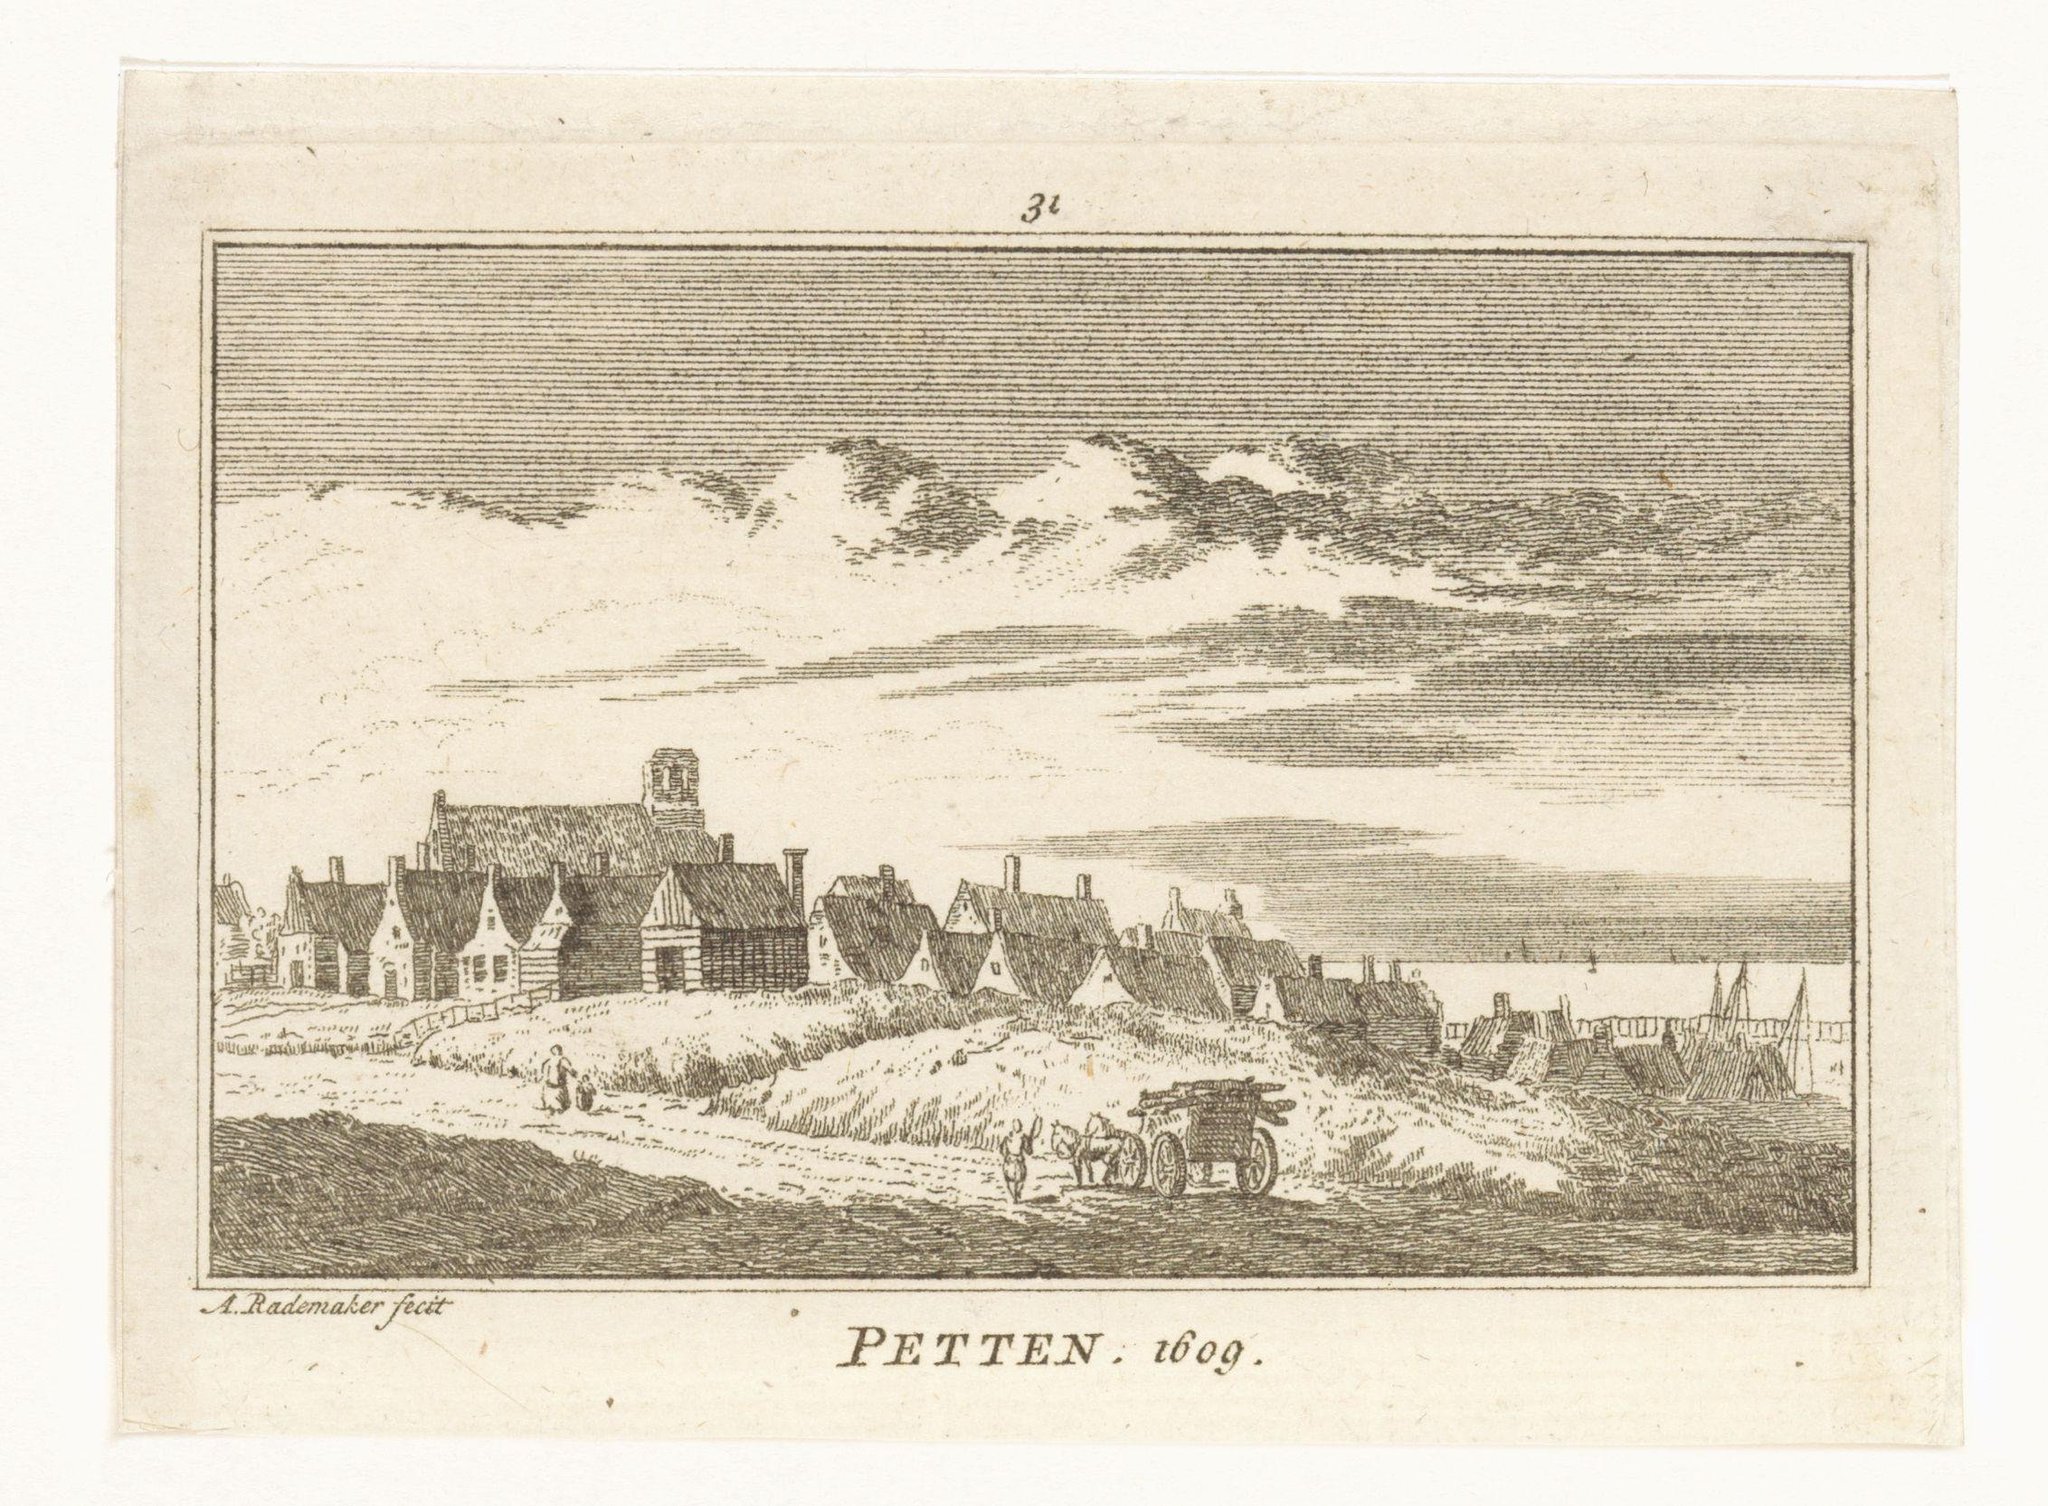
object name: book illustration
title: Gezicht op Petten, 1609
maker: abraham rademaker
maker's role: draughtsman, print maker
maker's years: 1676-1735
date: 1725-1803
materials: paper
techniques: engraving, etching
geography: amsterdam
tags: prospect of village, silhouette of village, sailing-ship, sailing-boat, public road in village, four-wheeled vehicle drawn by two animals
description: Prent ook gebruikt in: Rademaker, Abraham. Kabinet van Nederlandsche outheden en gezichten: vervat in 300 konstplaaten (…). 2 delen. Amsterdam: Willem Barents, 1725, dl. 1, ill. 31. Na 1725 is deze prent nog in verschillende heruitgaven verschenen, uitgegeven in 1727-1733, 1770-1771 en 1792-1803. Uit welke uitgave het huidige exemplaar precies komt is niet na te gaan.